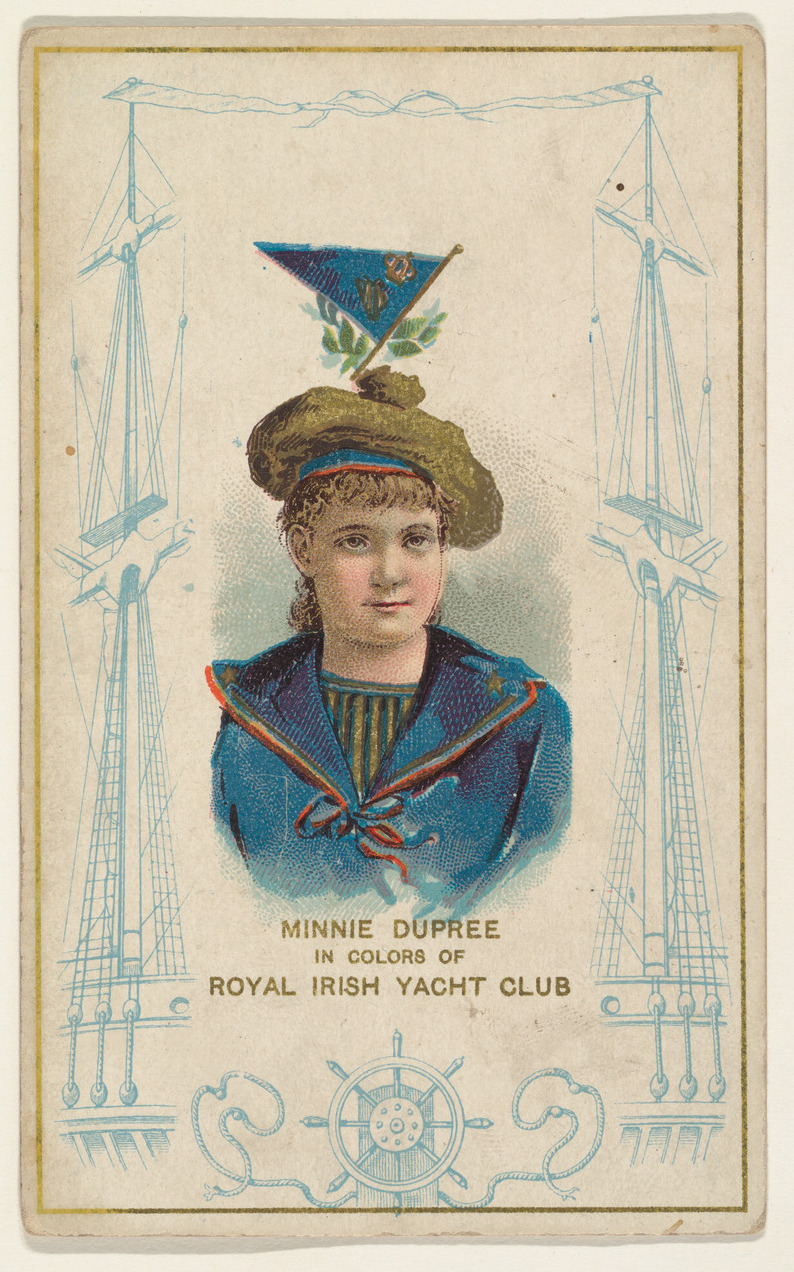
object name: print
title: Minnie Dupree in Colors of the Royal Irish Yacht Club, from the Yacht Colors of the World series (N140) issued by Duke Sons & Co. to promote Honest Long Cut Tobacco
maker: w. duke, sons & co.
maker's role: publisher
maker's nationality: american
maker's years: 1870-1920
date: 1890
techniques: color lithograph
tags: portraits,women